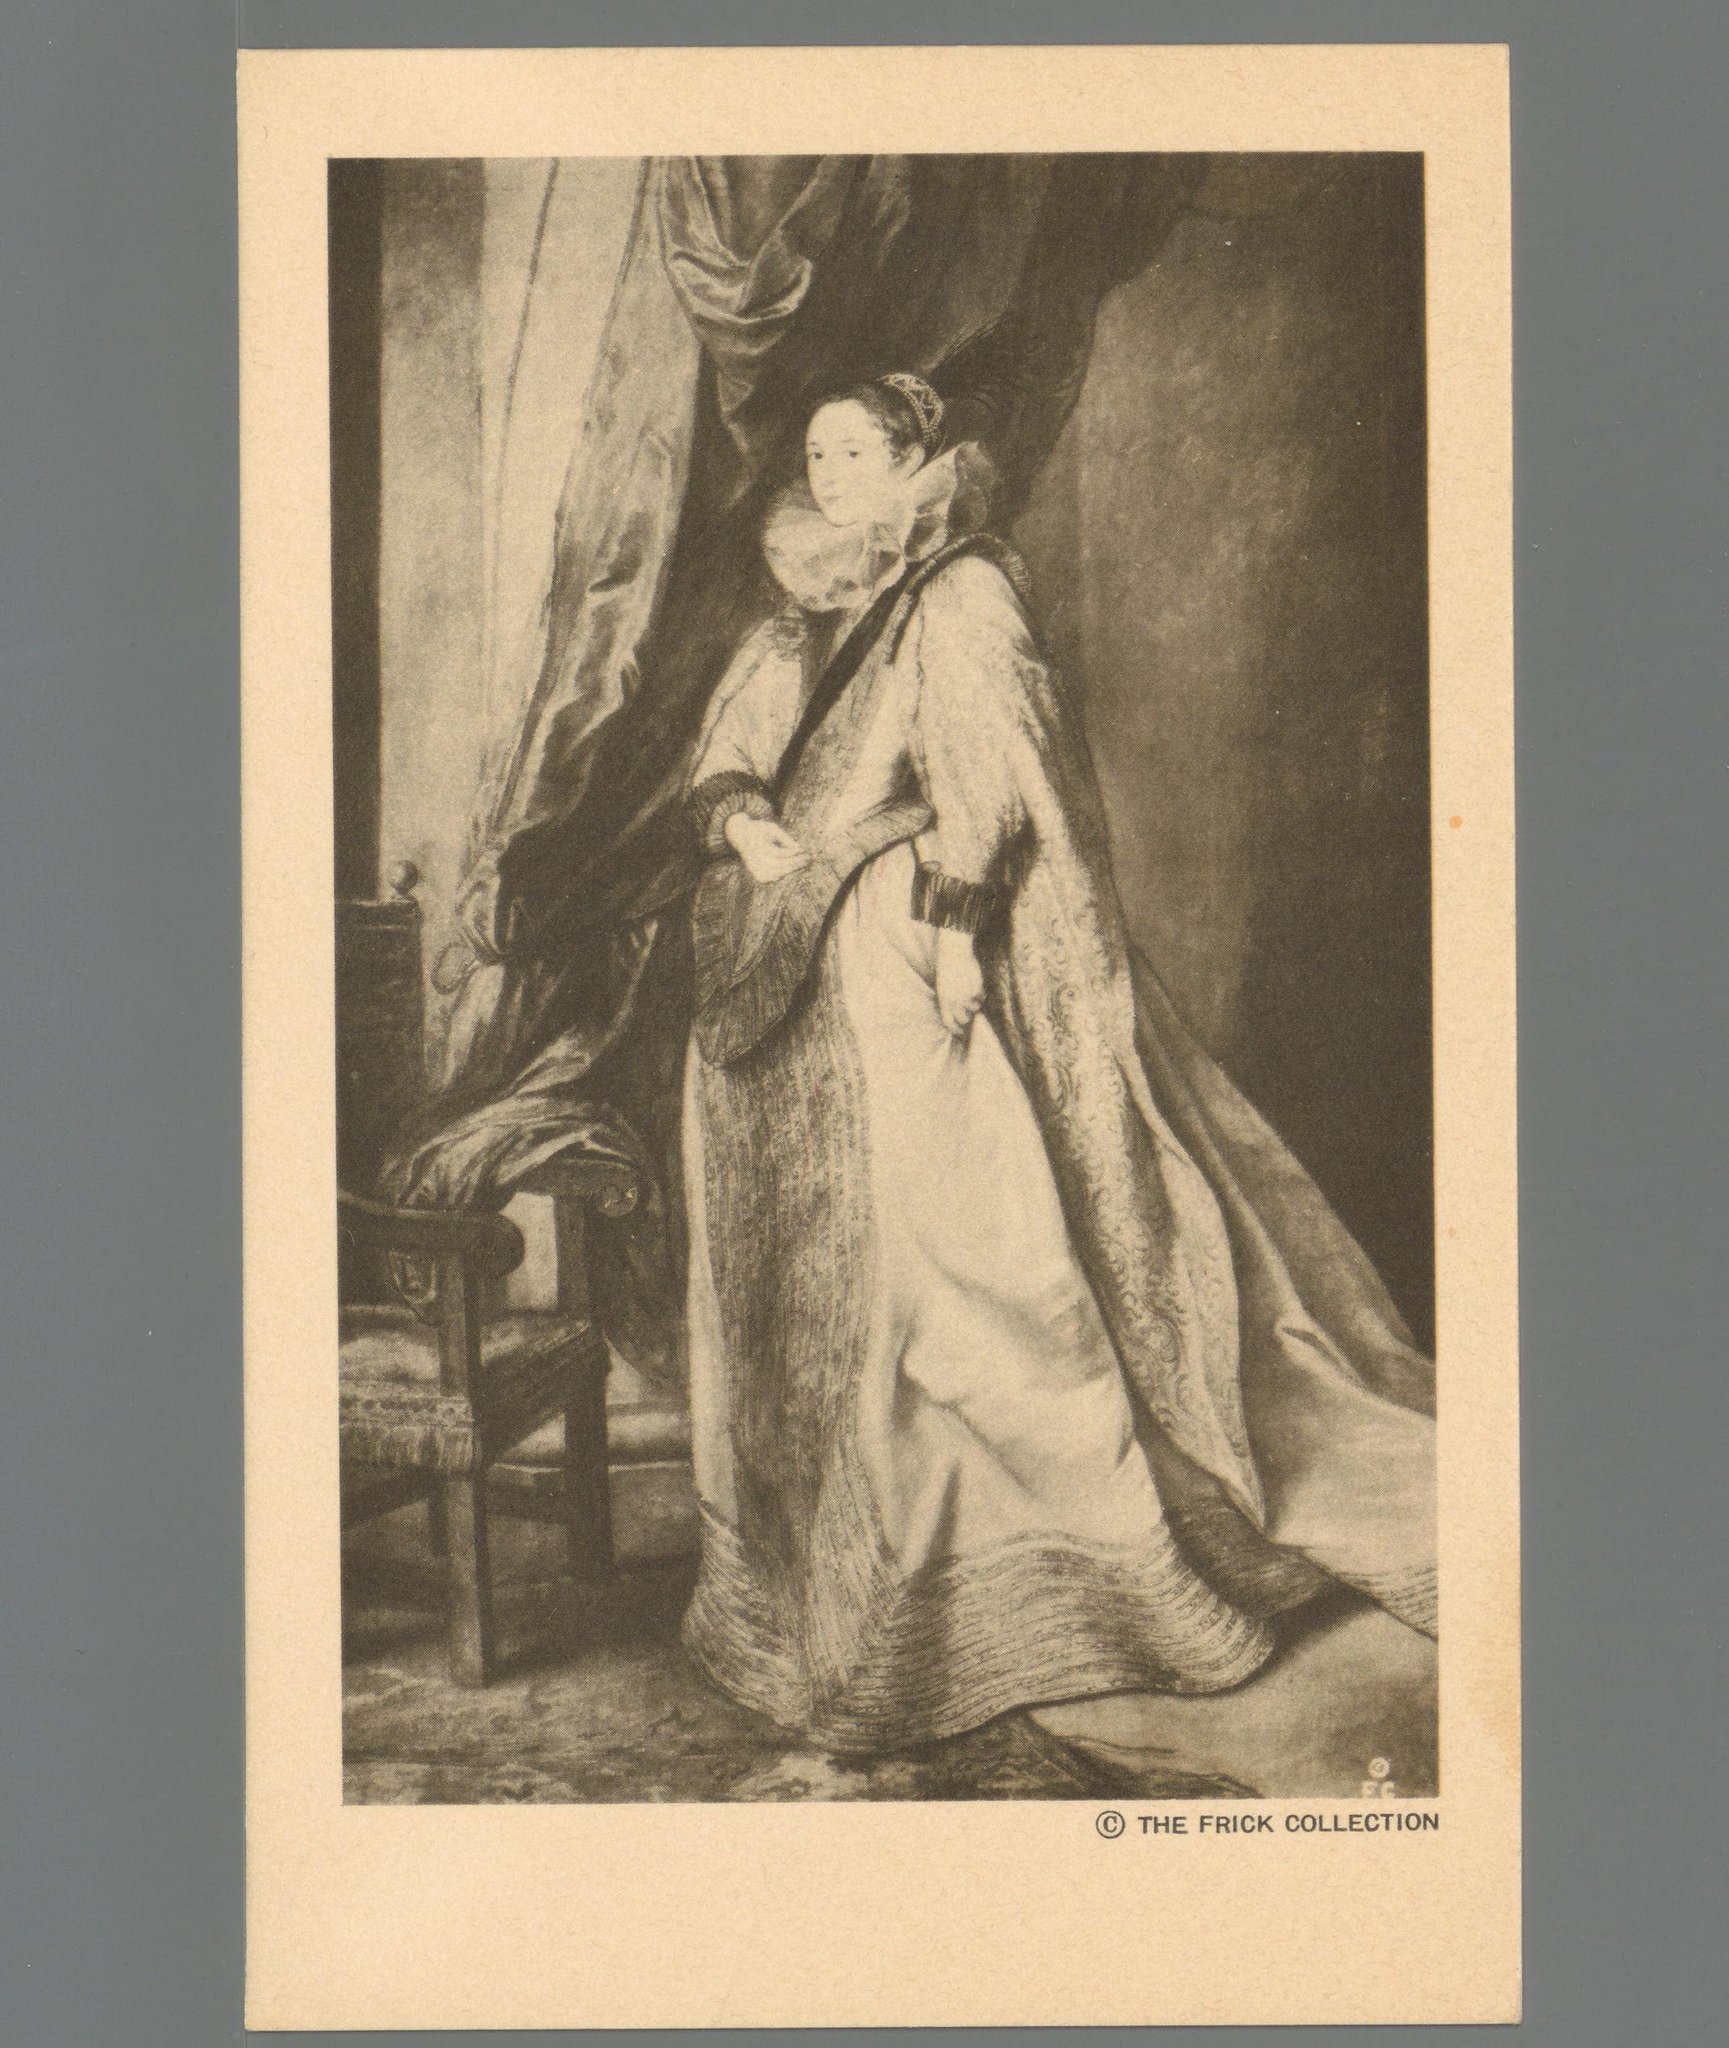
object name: photomechanical print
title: Paola Adorno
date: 1914-1940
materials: cardboard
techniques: rotogravure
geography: new york city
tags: historical persons, adult woman (+ standing), dress, gown